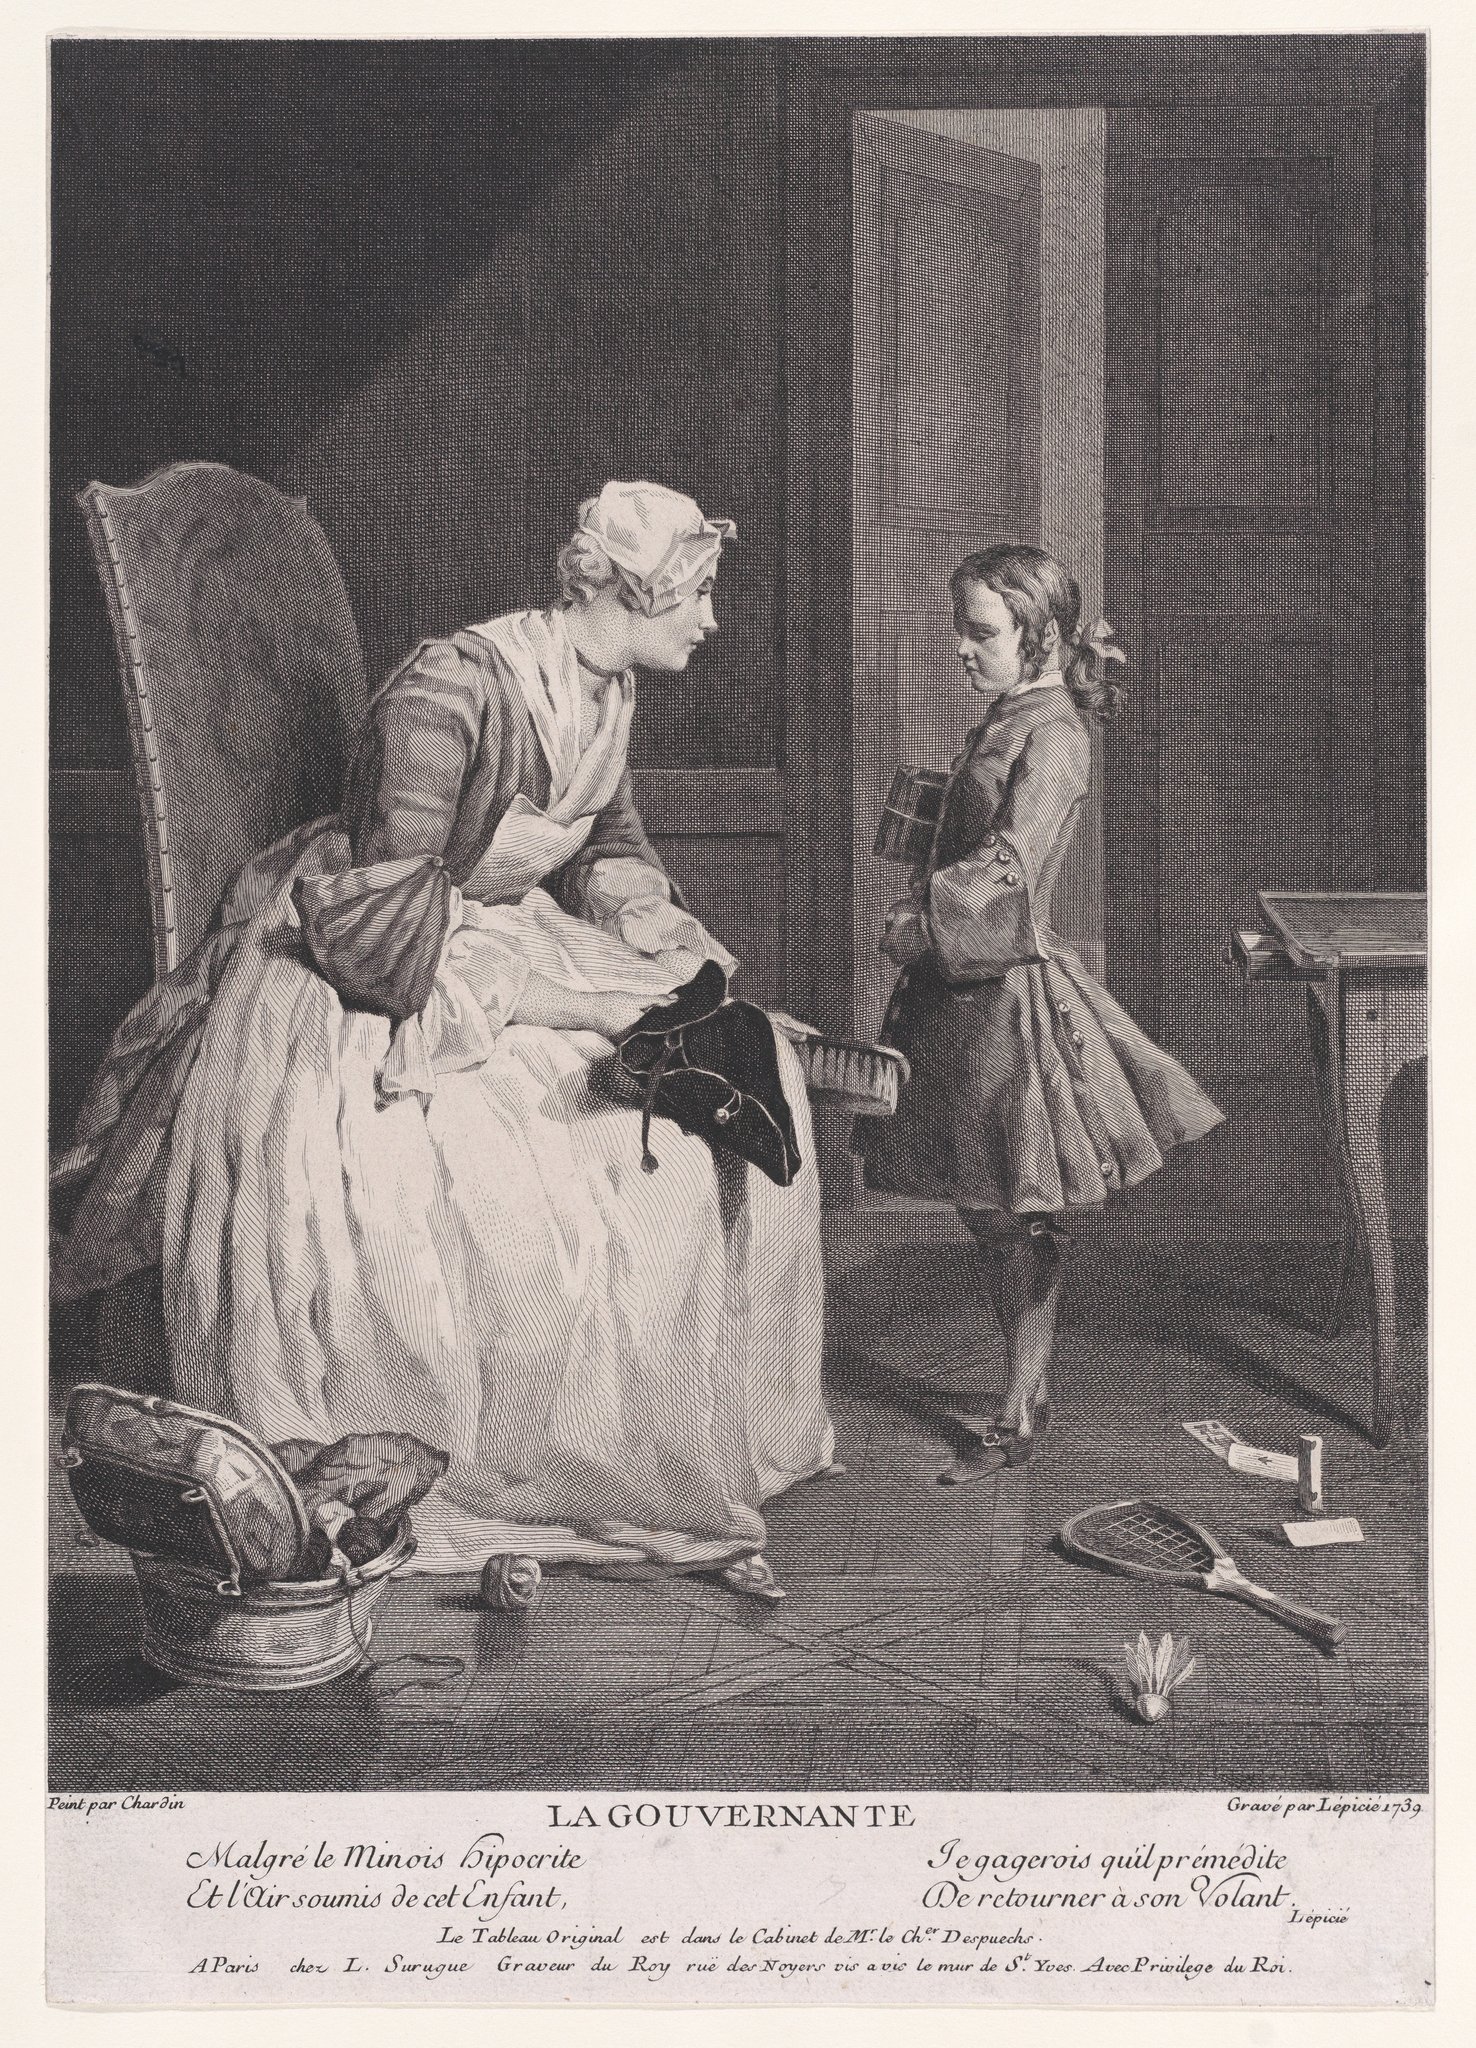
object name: print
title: The Governess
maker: bernard lepicié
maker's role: artist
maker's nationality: french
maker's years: 1698-1755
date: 1739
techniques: engraving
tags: hats,boys,women,toys